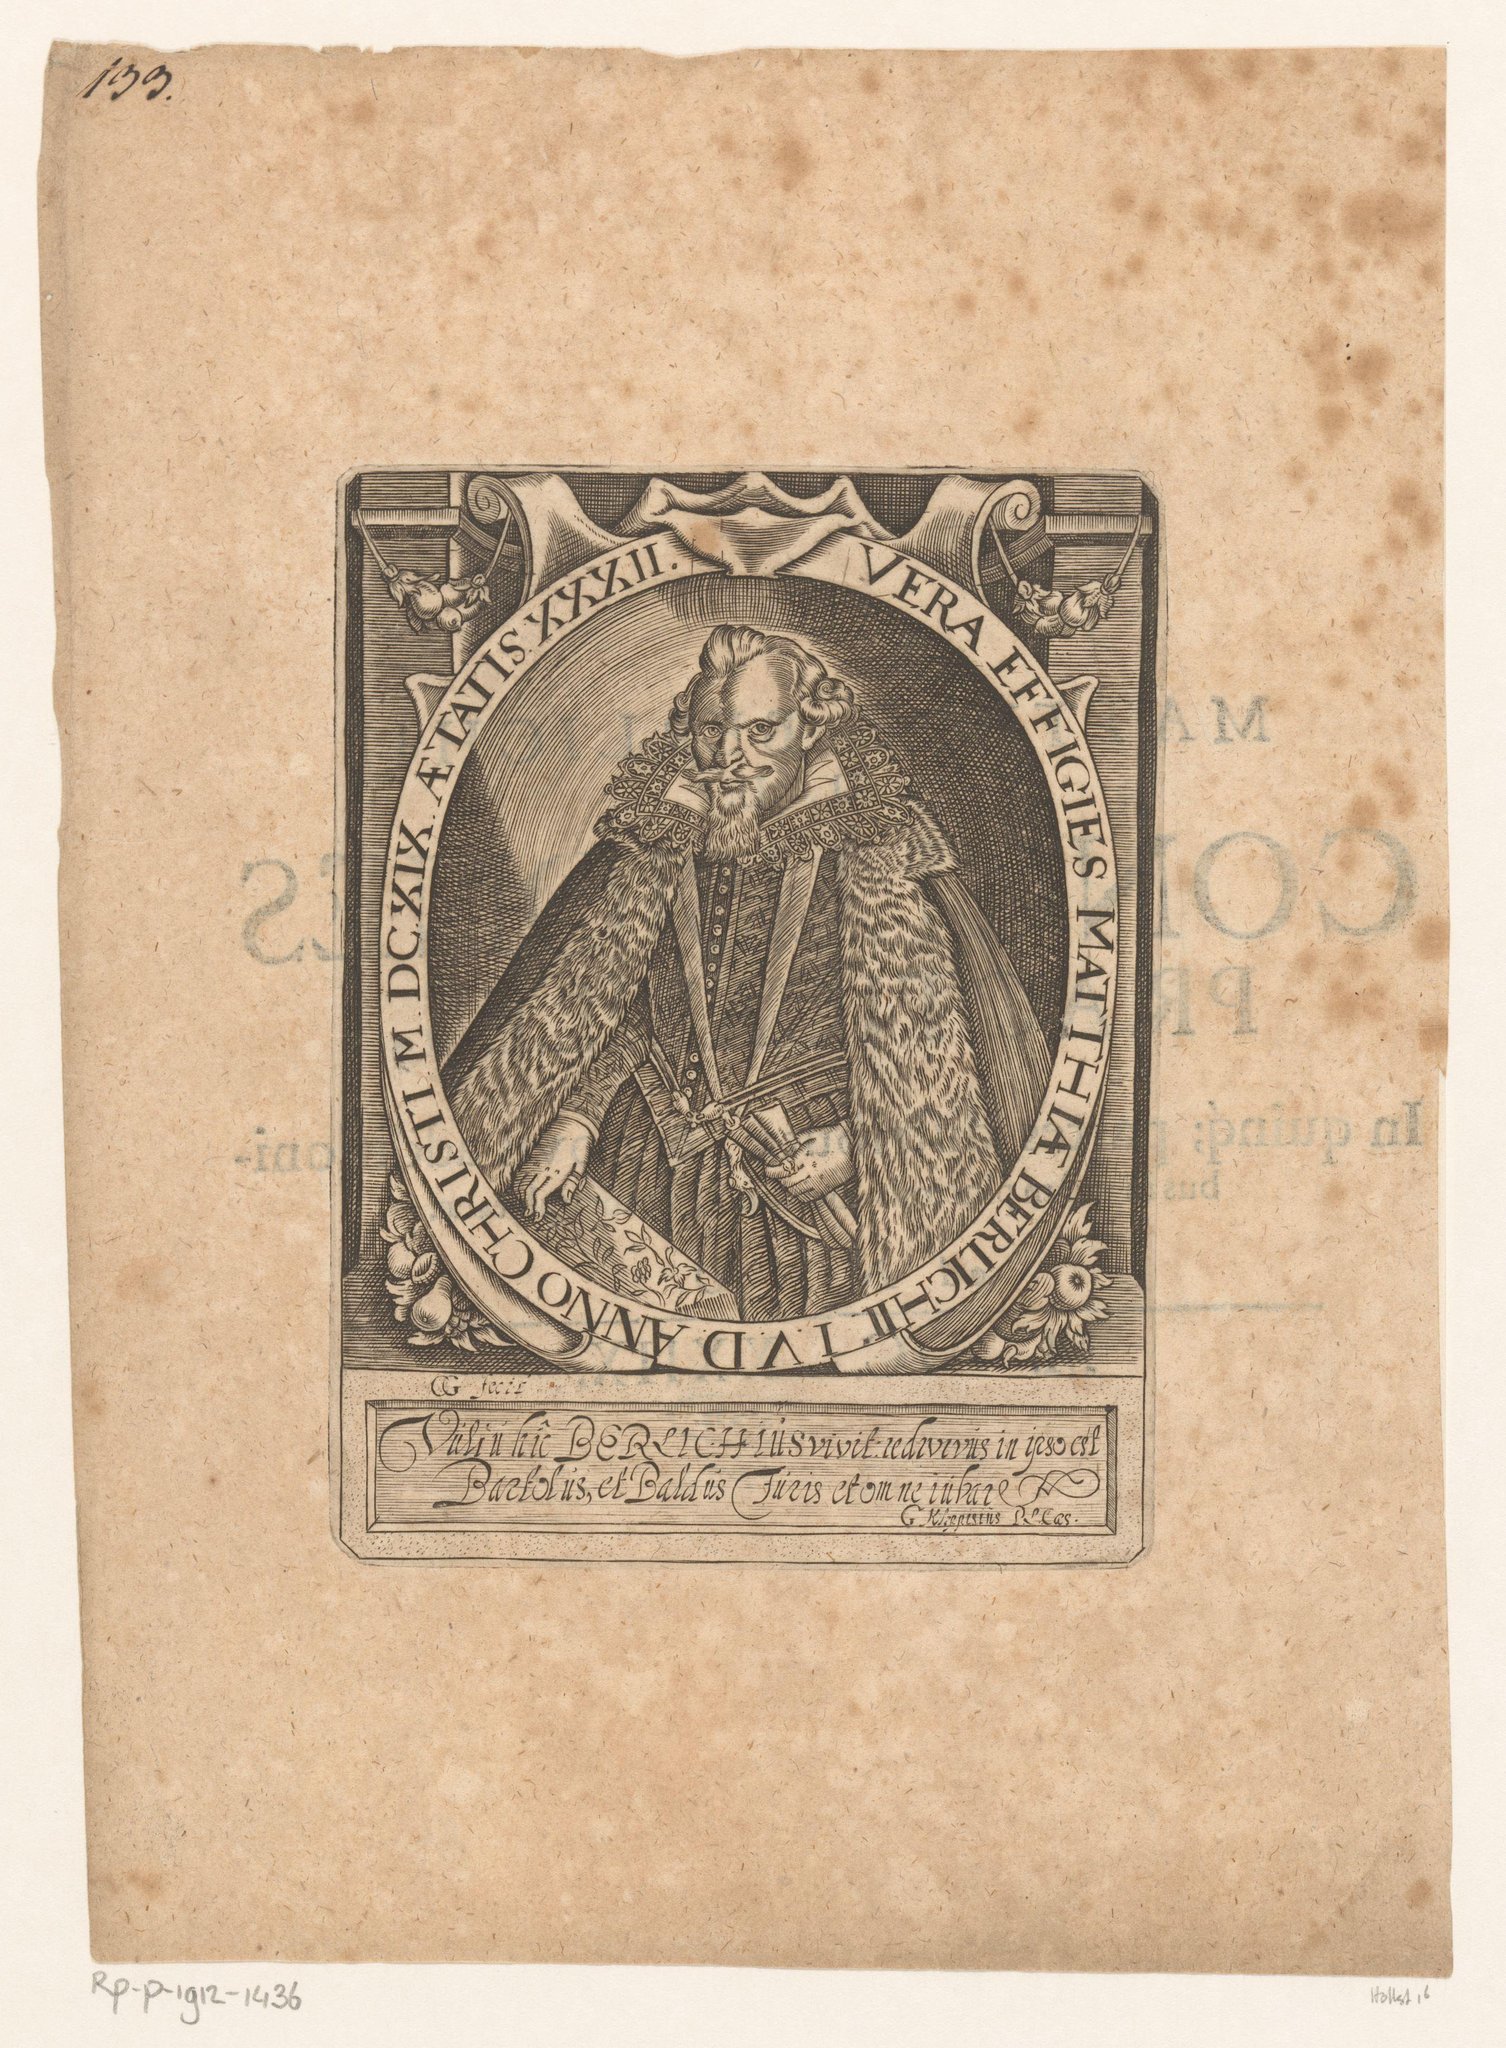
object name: print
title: Portret van Matthias Berlich op 32-jarige leeftijd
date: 1628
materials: paper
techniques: engraving, letterpress printing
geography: leipzig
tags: gloves, mittens, etc., ornament ~ medallion, historical persons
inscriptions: collector's mark: Lugt 2228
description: Prent uit: Berlich, Matthias. Conclusiones Practicabiles (...). Leipzig: Grosse, 1628.